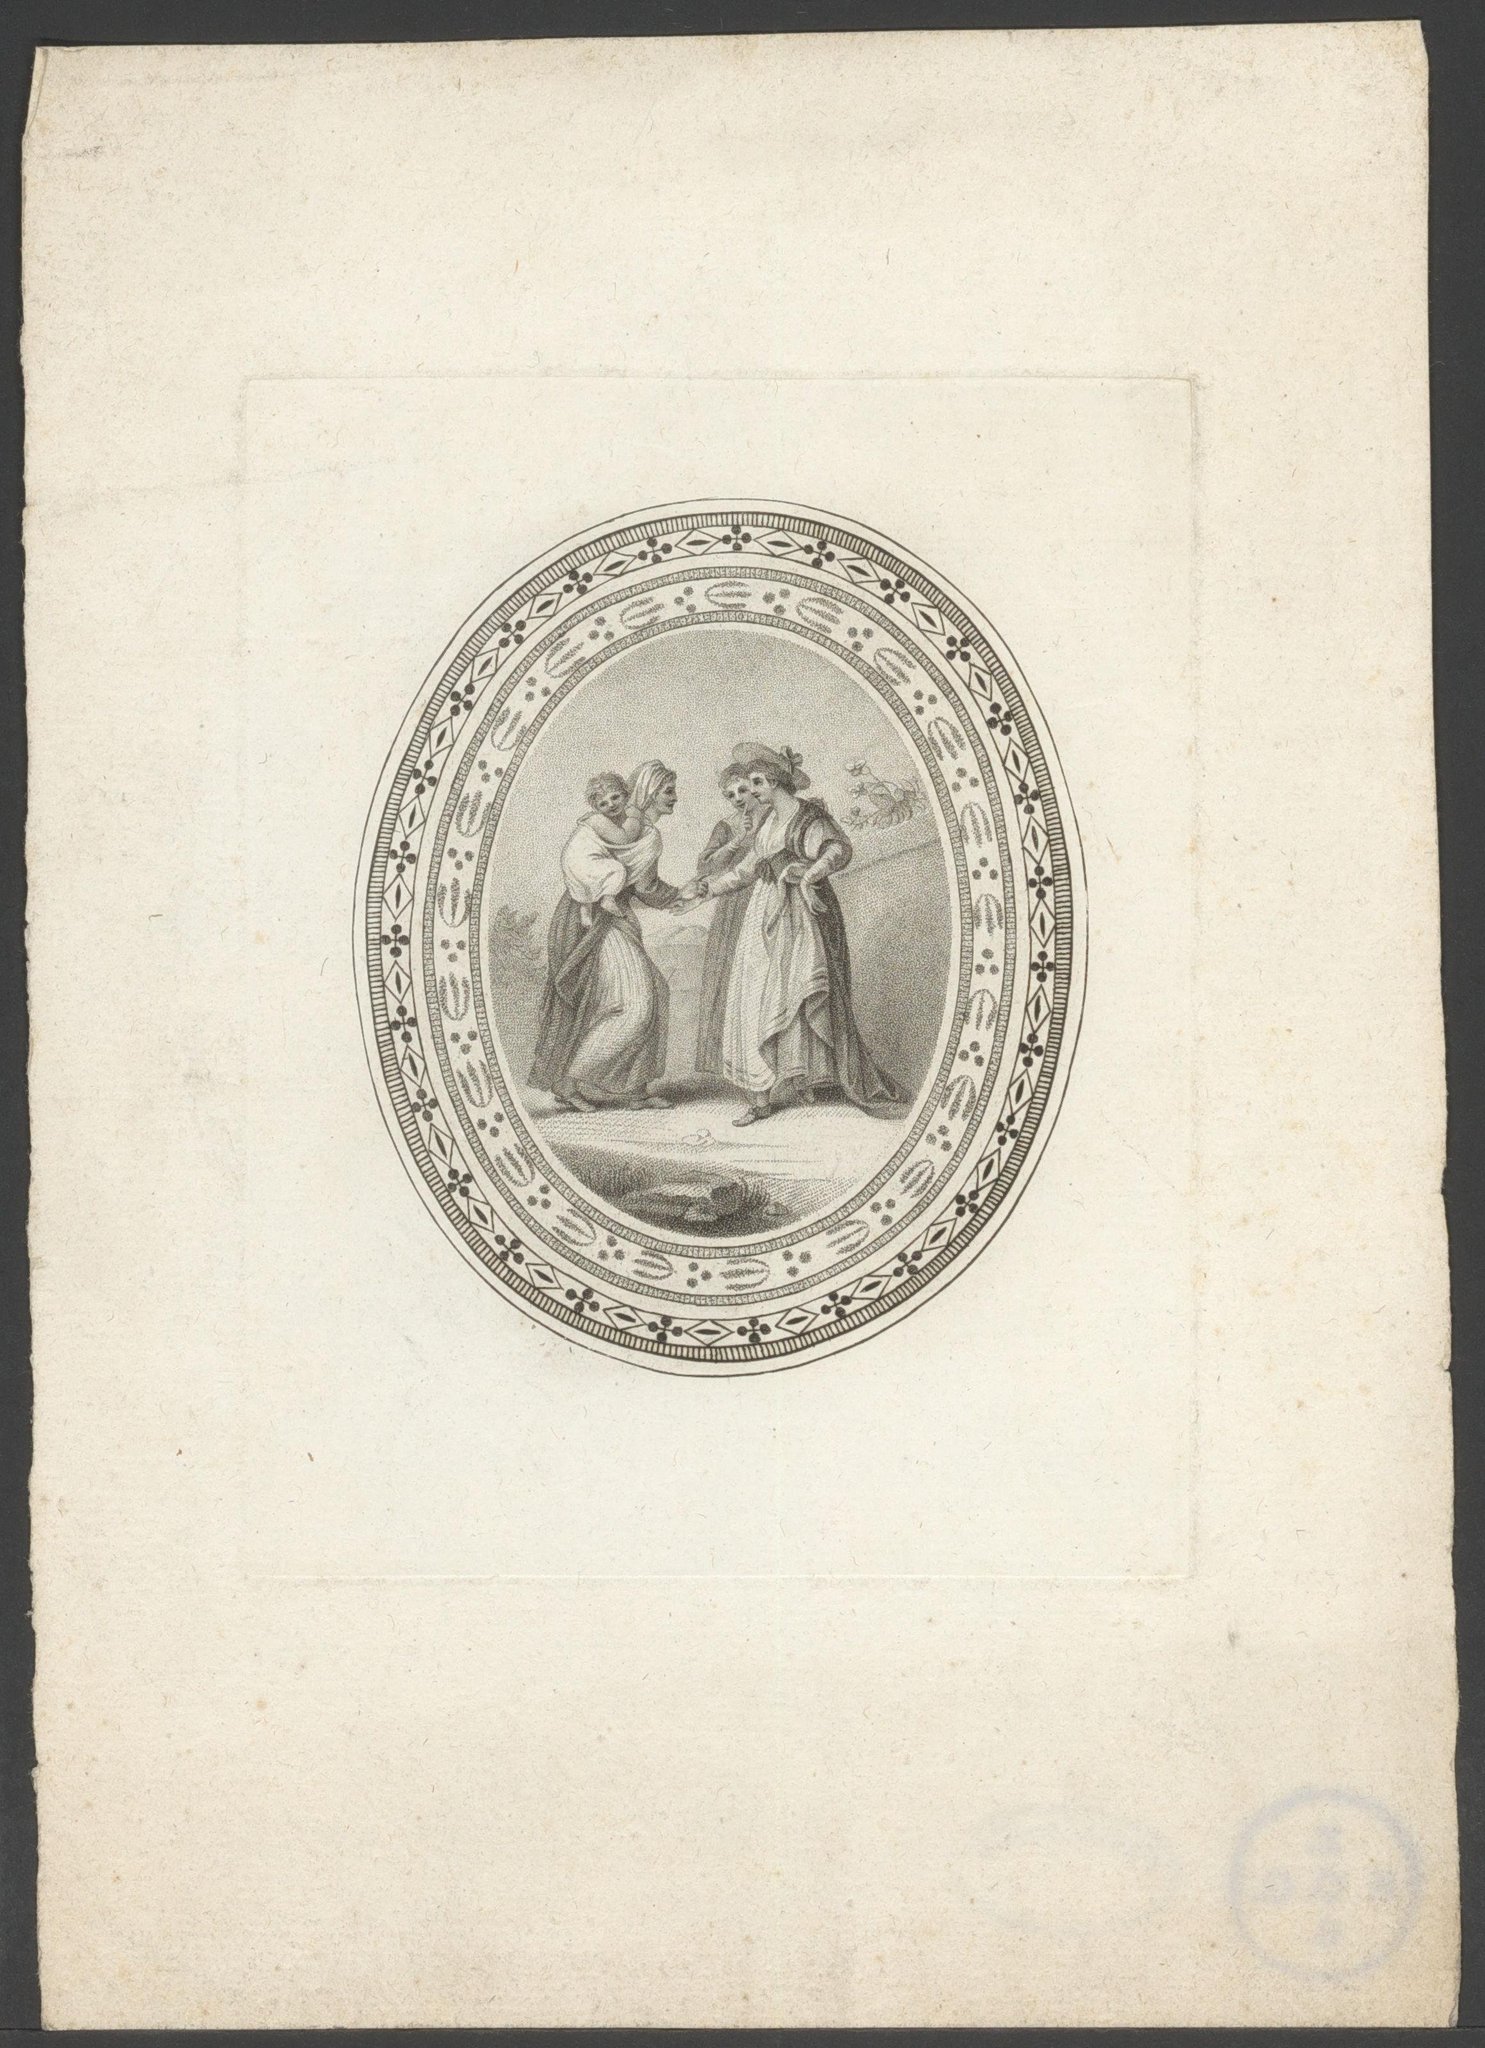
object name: print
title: Vrouw met kind op haar rug groet twee andere vrouwen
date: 1775-1825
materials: paper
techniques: etching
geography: london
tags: shaking hands, 'dextrarum junctio', standing figure (canon, proportions) - aa - female human figure, child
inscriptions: collector's mark: Lugt 1641, stamp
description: Onderwerpsrubrieken binnen de Atlas Zeden en Gewoonten: Schoone kunsten, Varia.